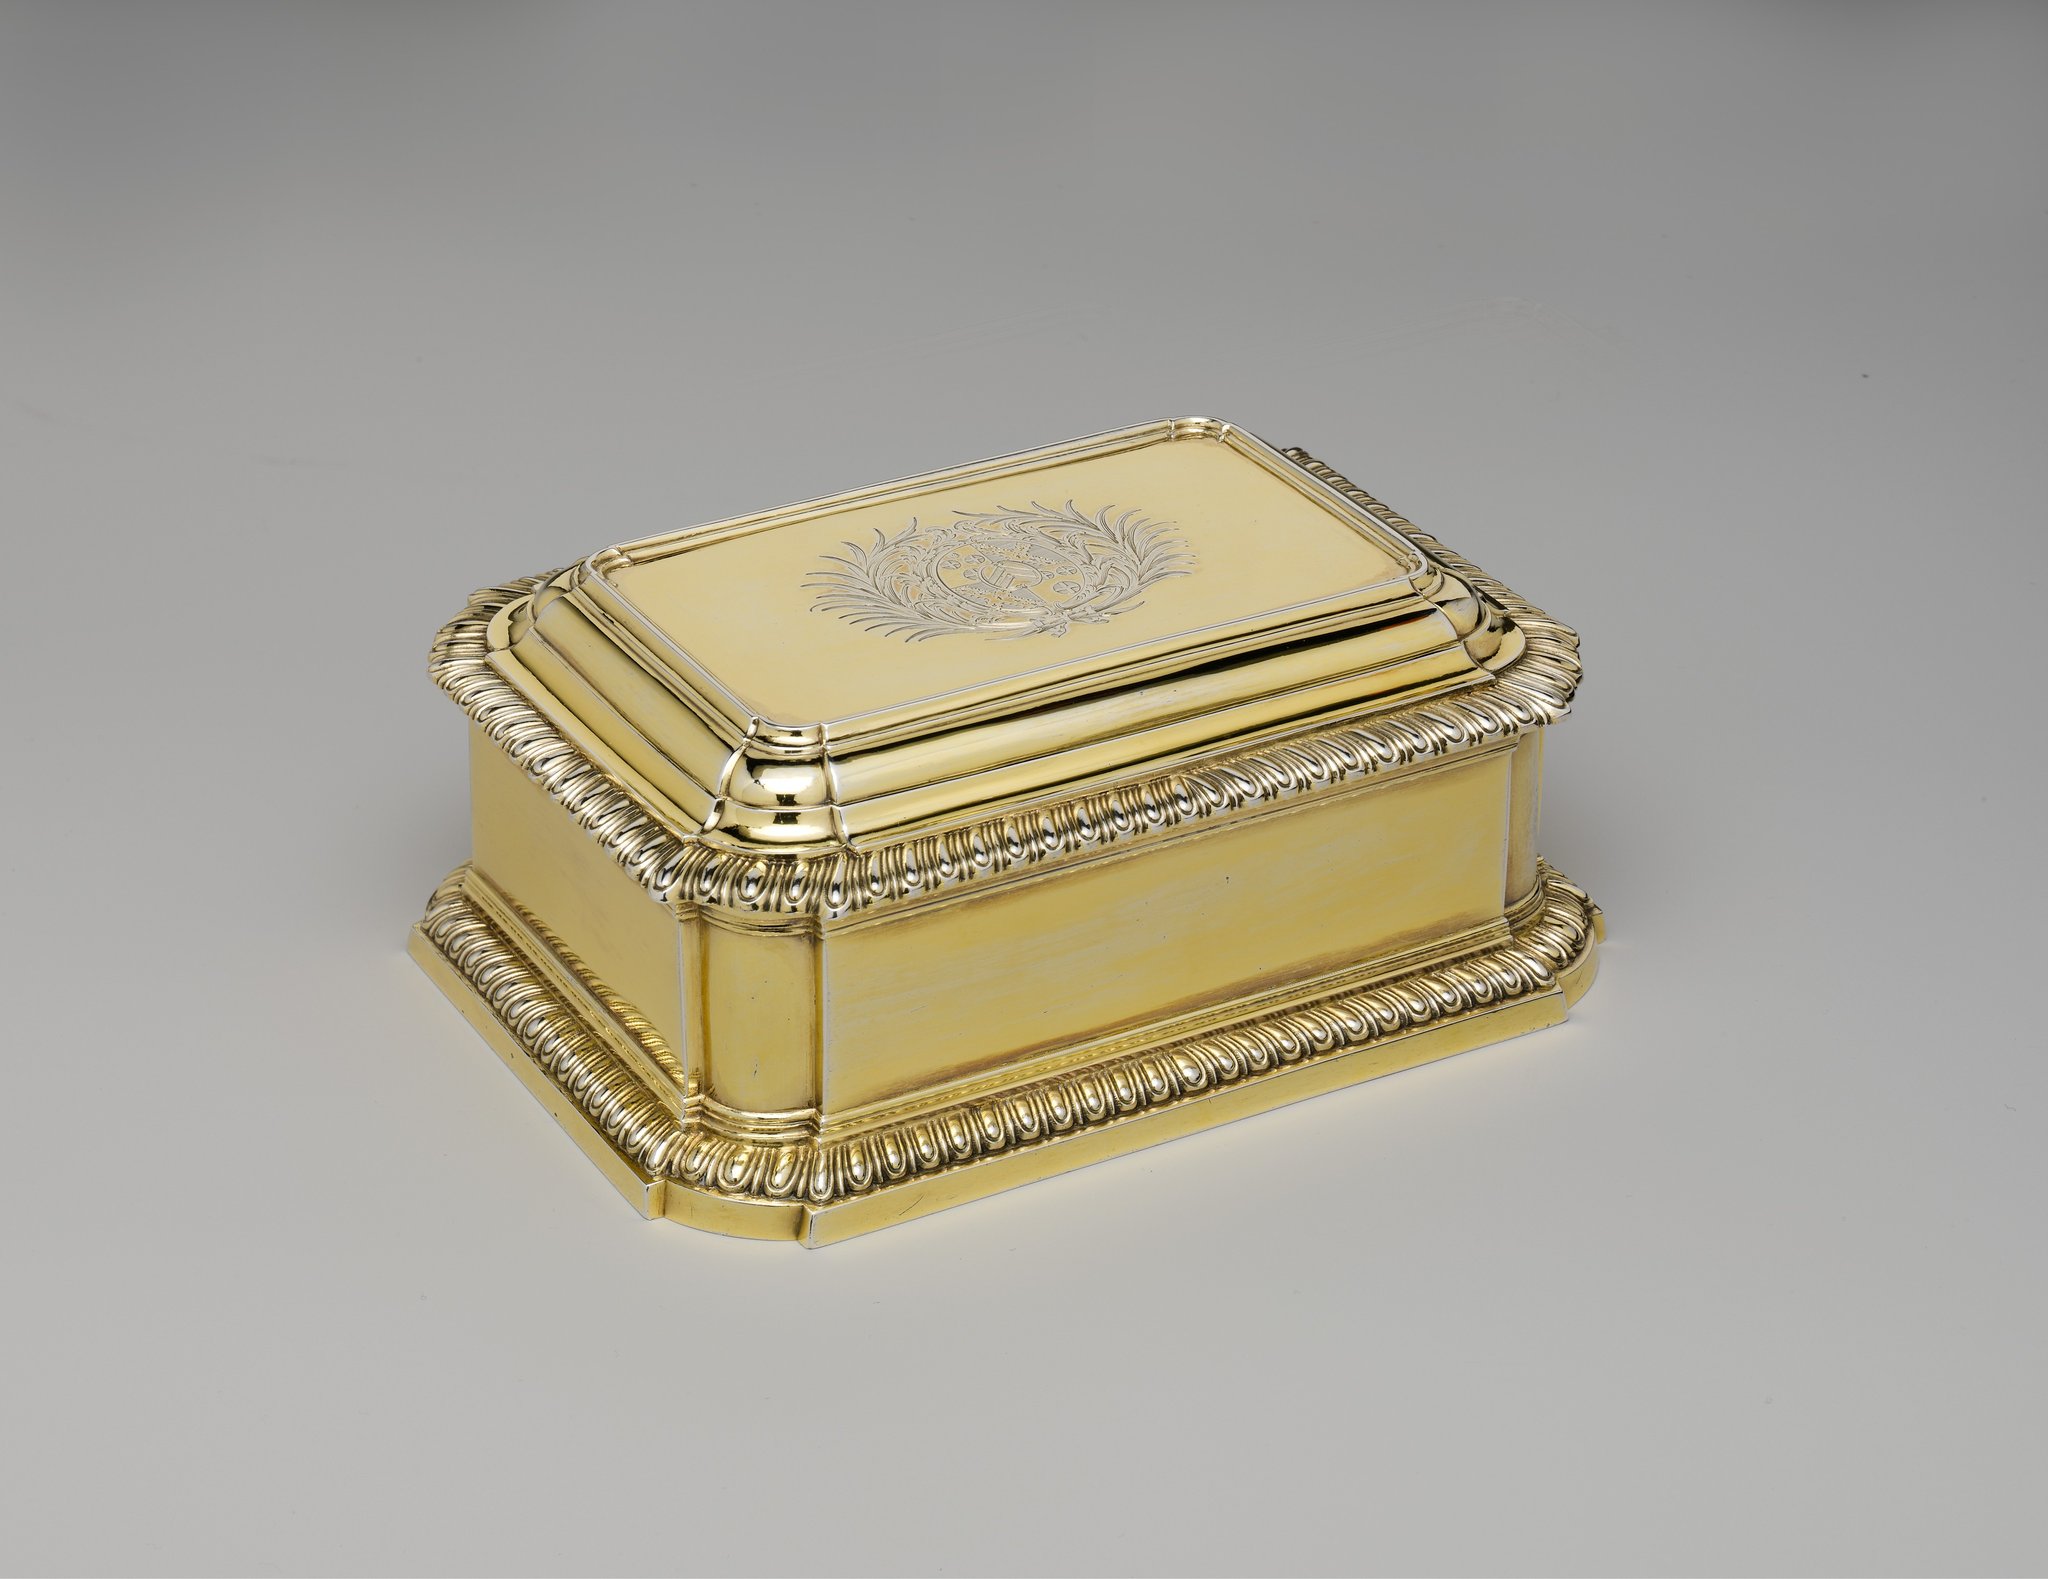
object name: box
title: Box (one of a pair) (part of a set)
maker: john parker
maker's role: maker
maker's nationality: british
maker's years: 1759-1777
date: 1766-1767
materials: silver gilt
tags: coat of arms